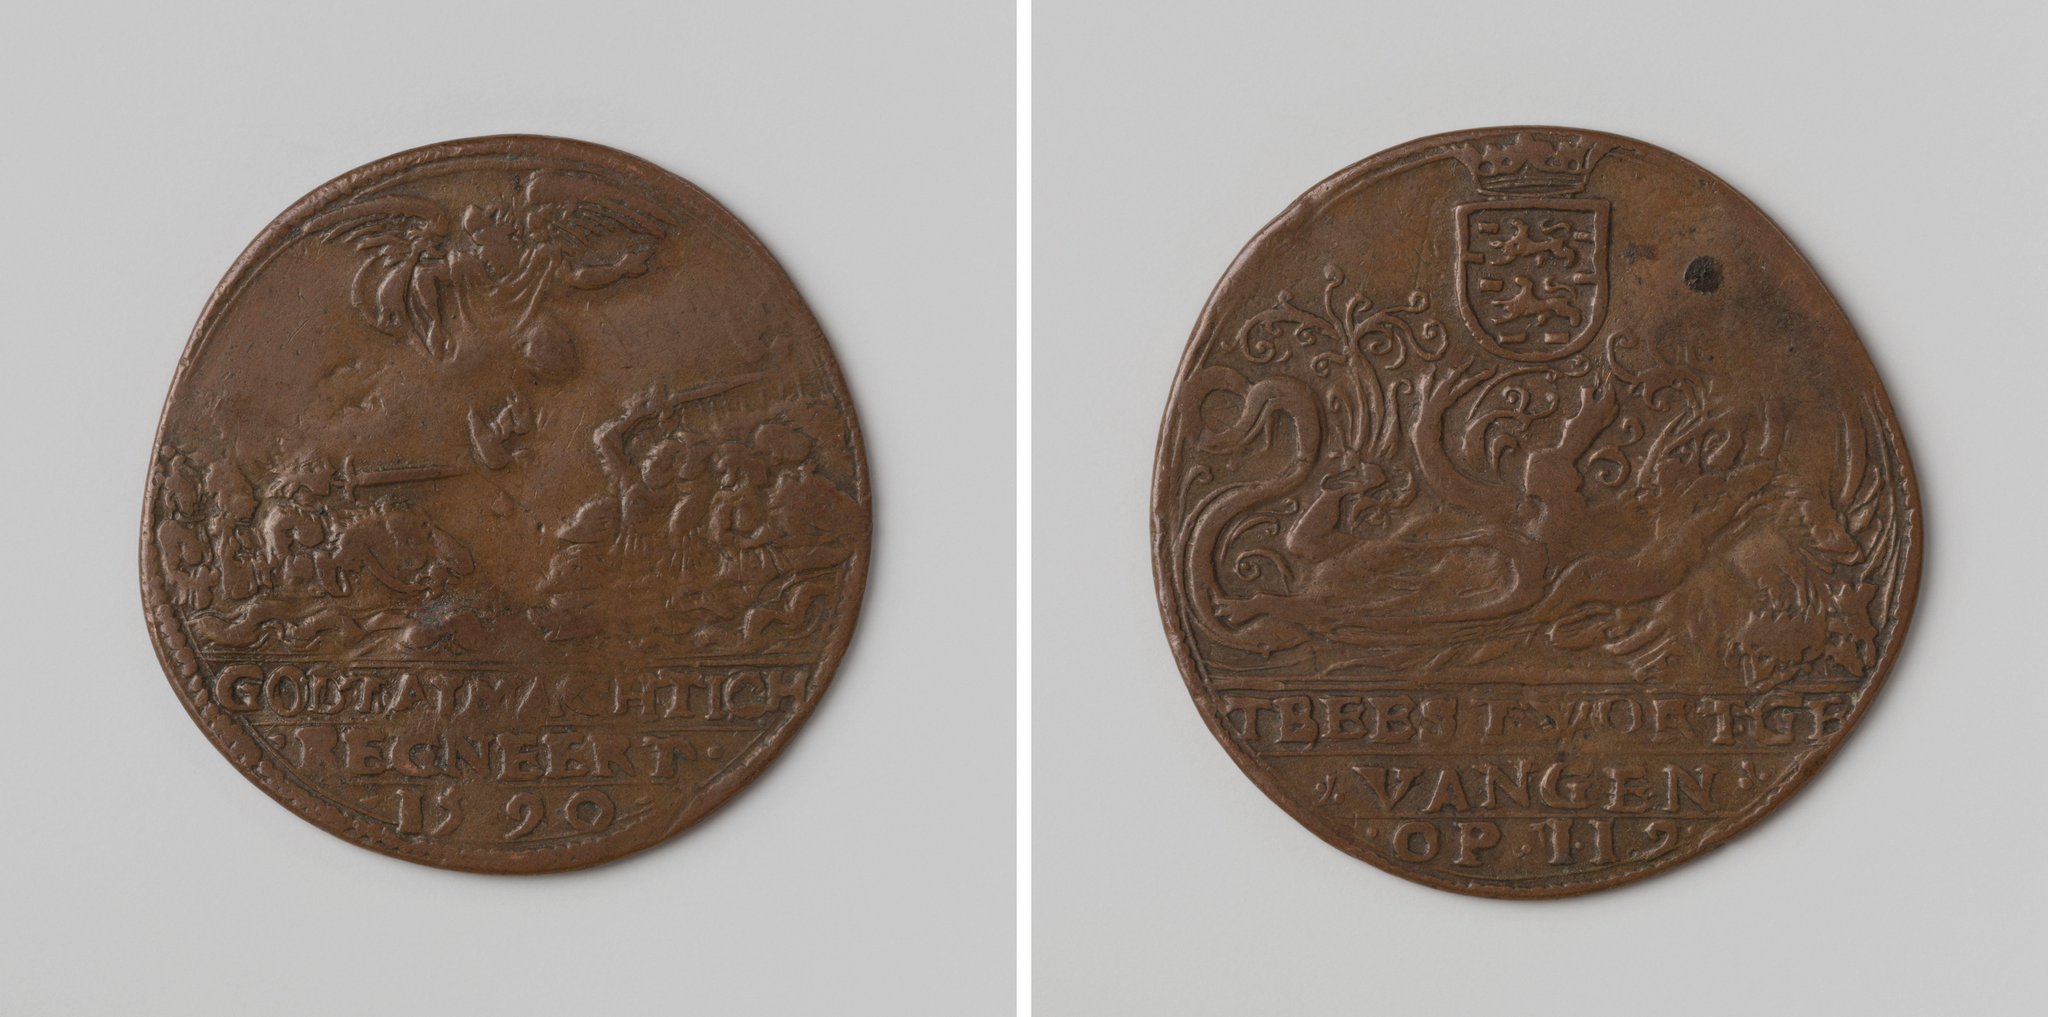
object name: jeton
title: Edict van de Staten van Holland tegen de roomskatholieke godsdienst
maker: Anonymous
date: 1590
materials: copper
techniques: striking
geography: hoorn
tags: holland